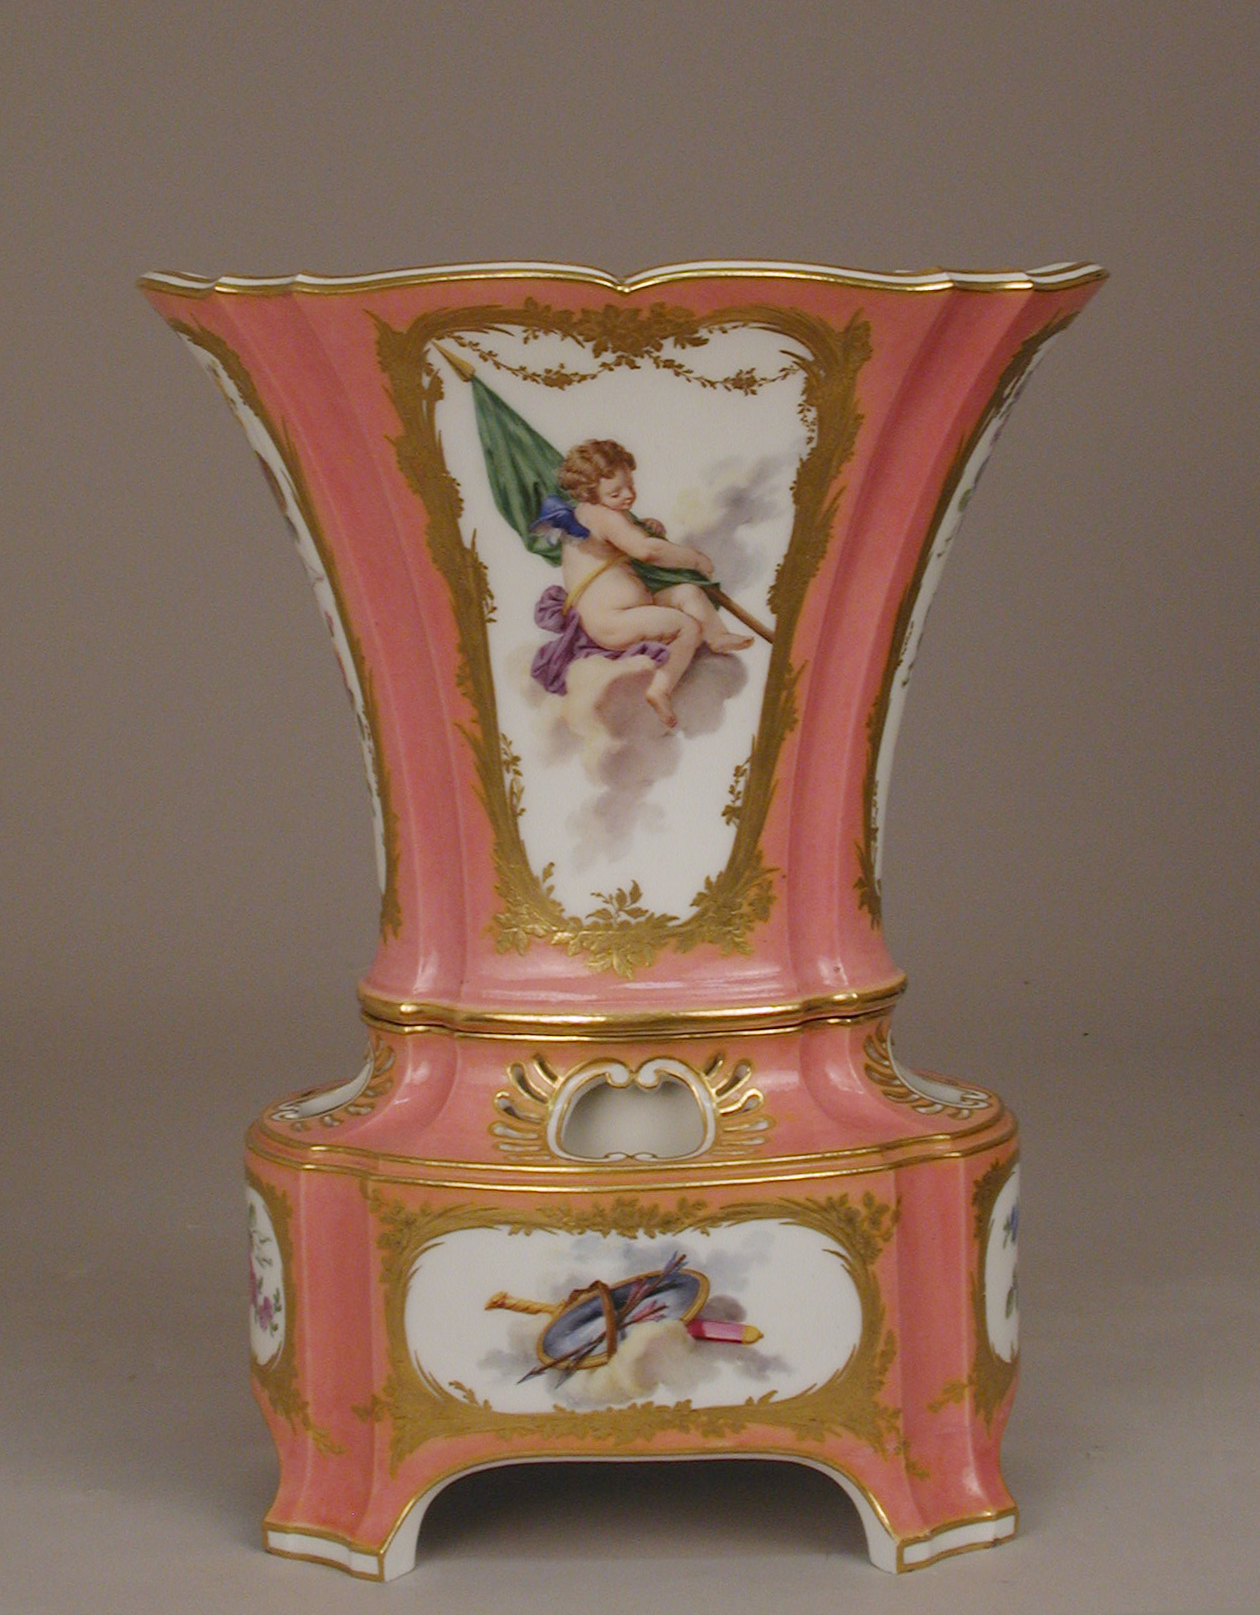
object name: vase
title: Vase (vase hollandois nouveau ovale) (one of a pair) (part of a set)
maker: sèvres manufactory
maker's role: manufactory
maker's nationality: french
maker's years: 1740-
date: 1763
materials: soft paste porcelain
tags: putti,flags